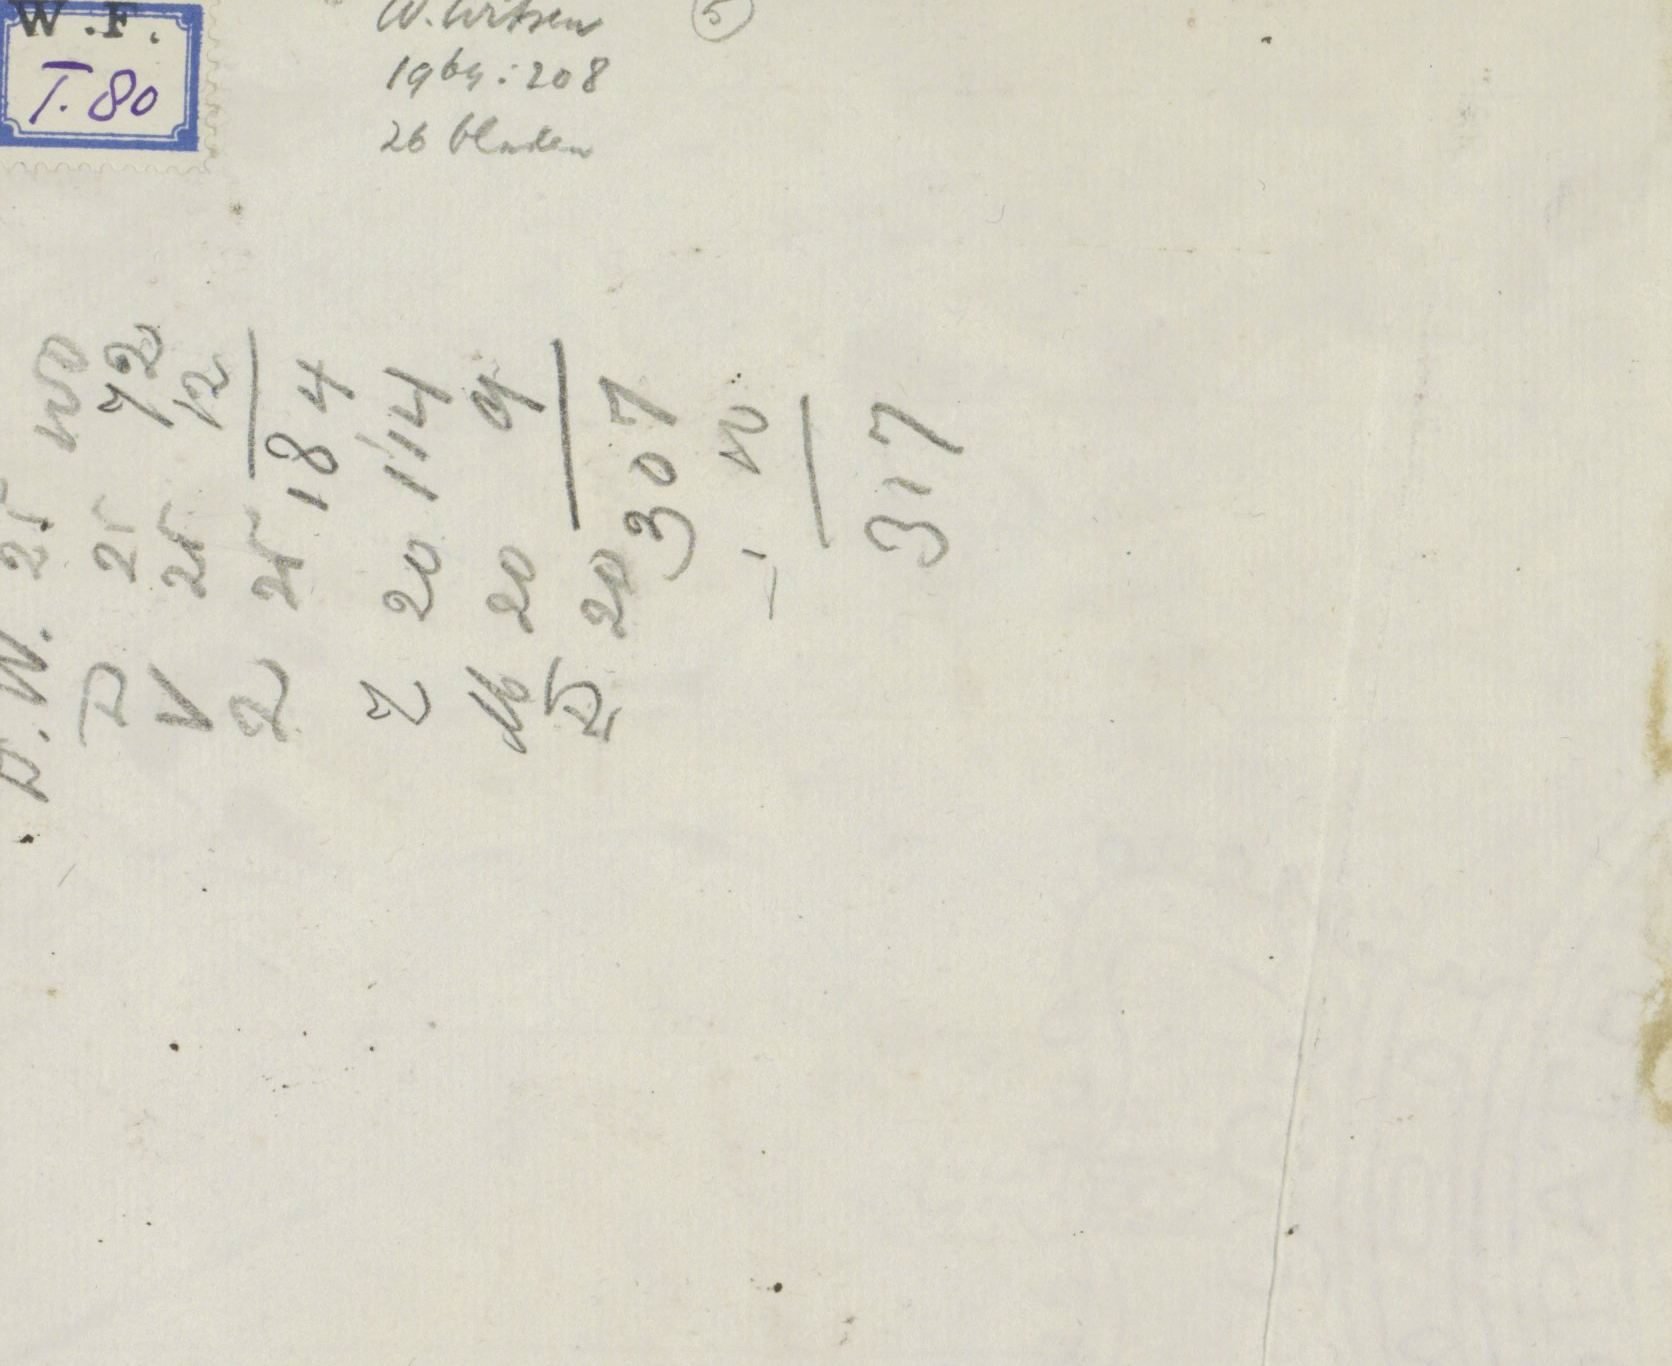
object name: endleaf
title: Annotaties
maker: willem witsen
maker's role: draughtsman, painter, print maker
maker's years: 1860-1923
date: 1914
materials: paper, pencil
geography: venice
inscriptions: watermark, annotation: ‘T. 80/ [...]’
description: Schutblad A, voorste schutblad, uit een schetsboek met 26 bladen.